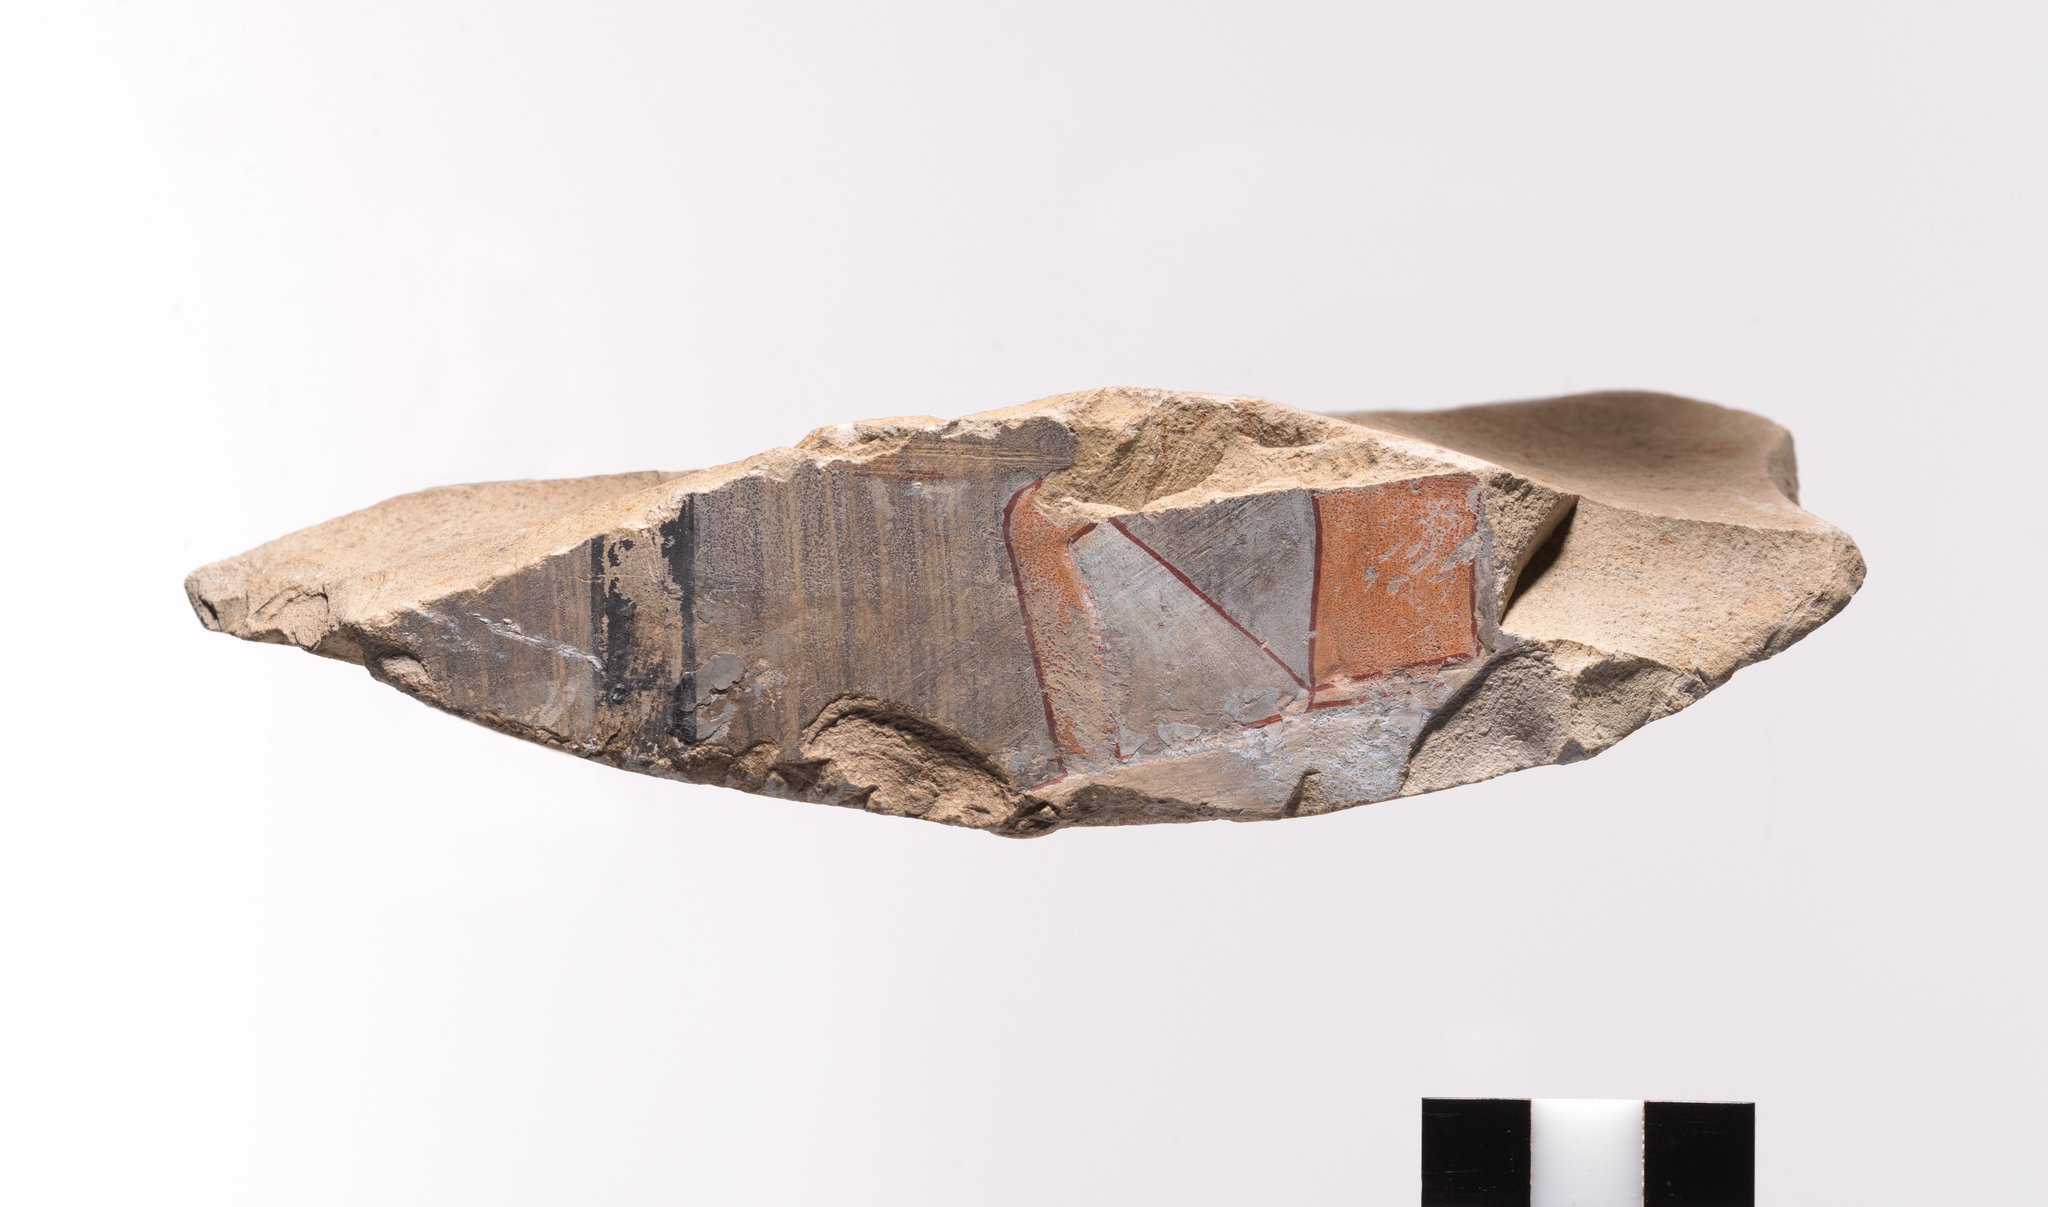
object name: relief fragment, tomb of meketre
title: Relief Fragment with Part of a Hieroglyph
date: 1981-1975 BCE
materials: limestone, paint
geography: egypt